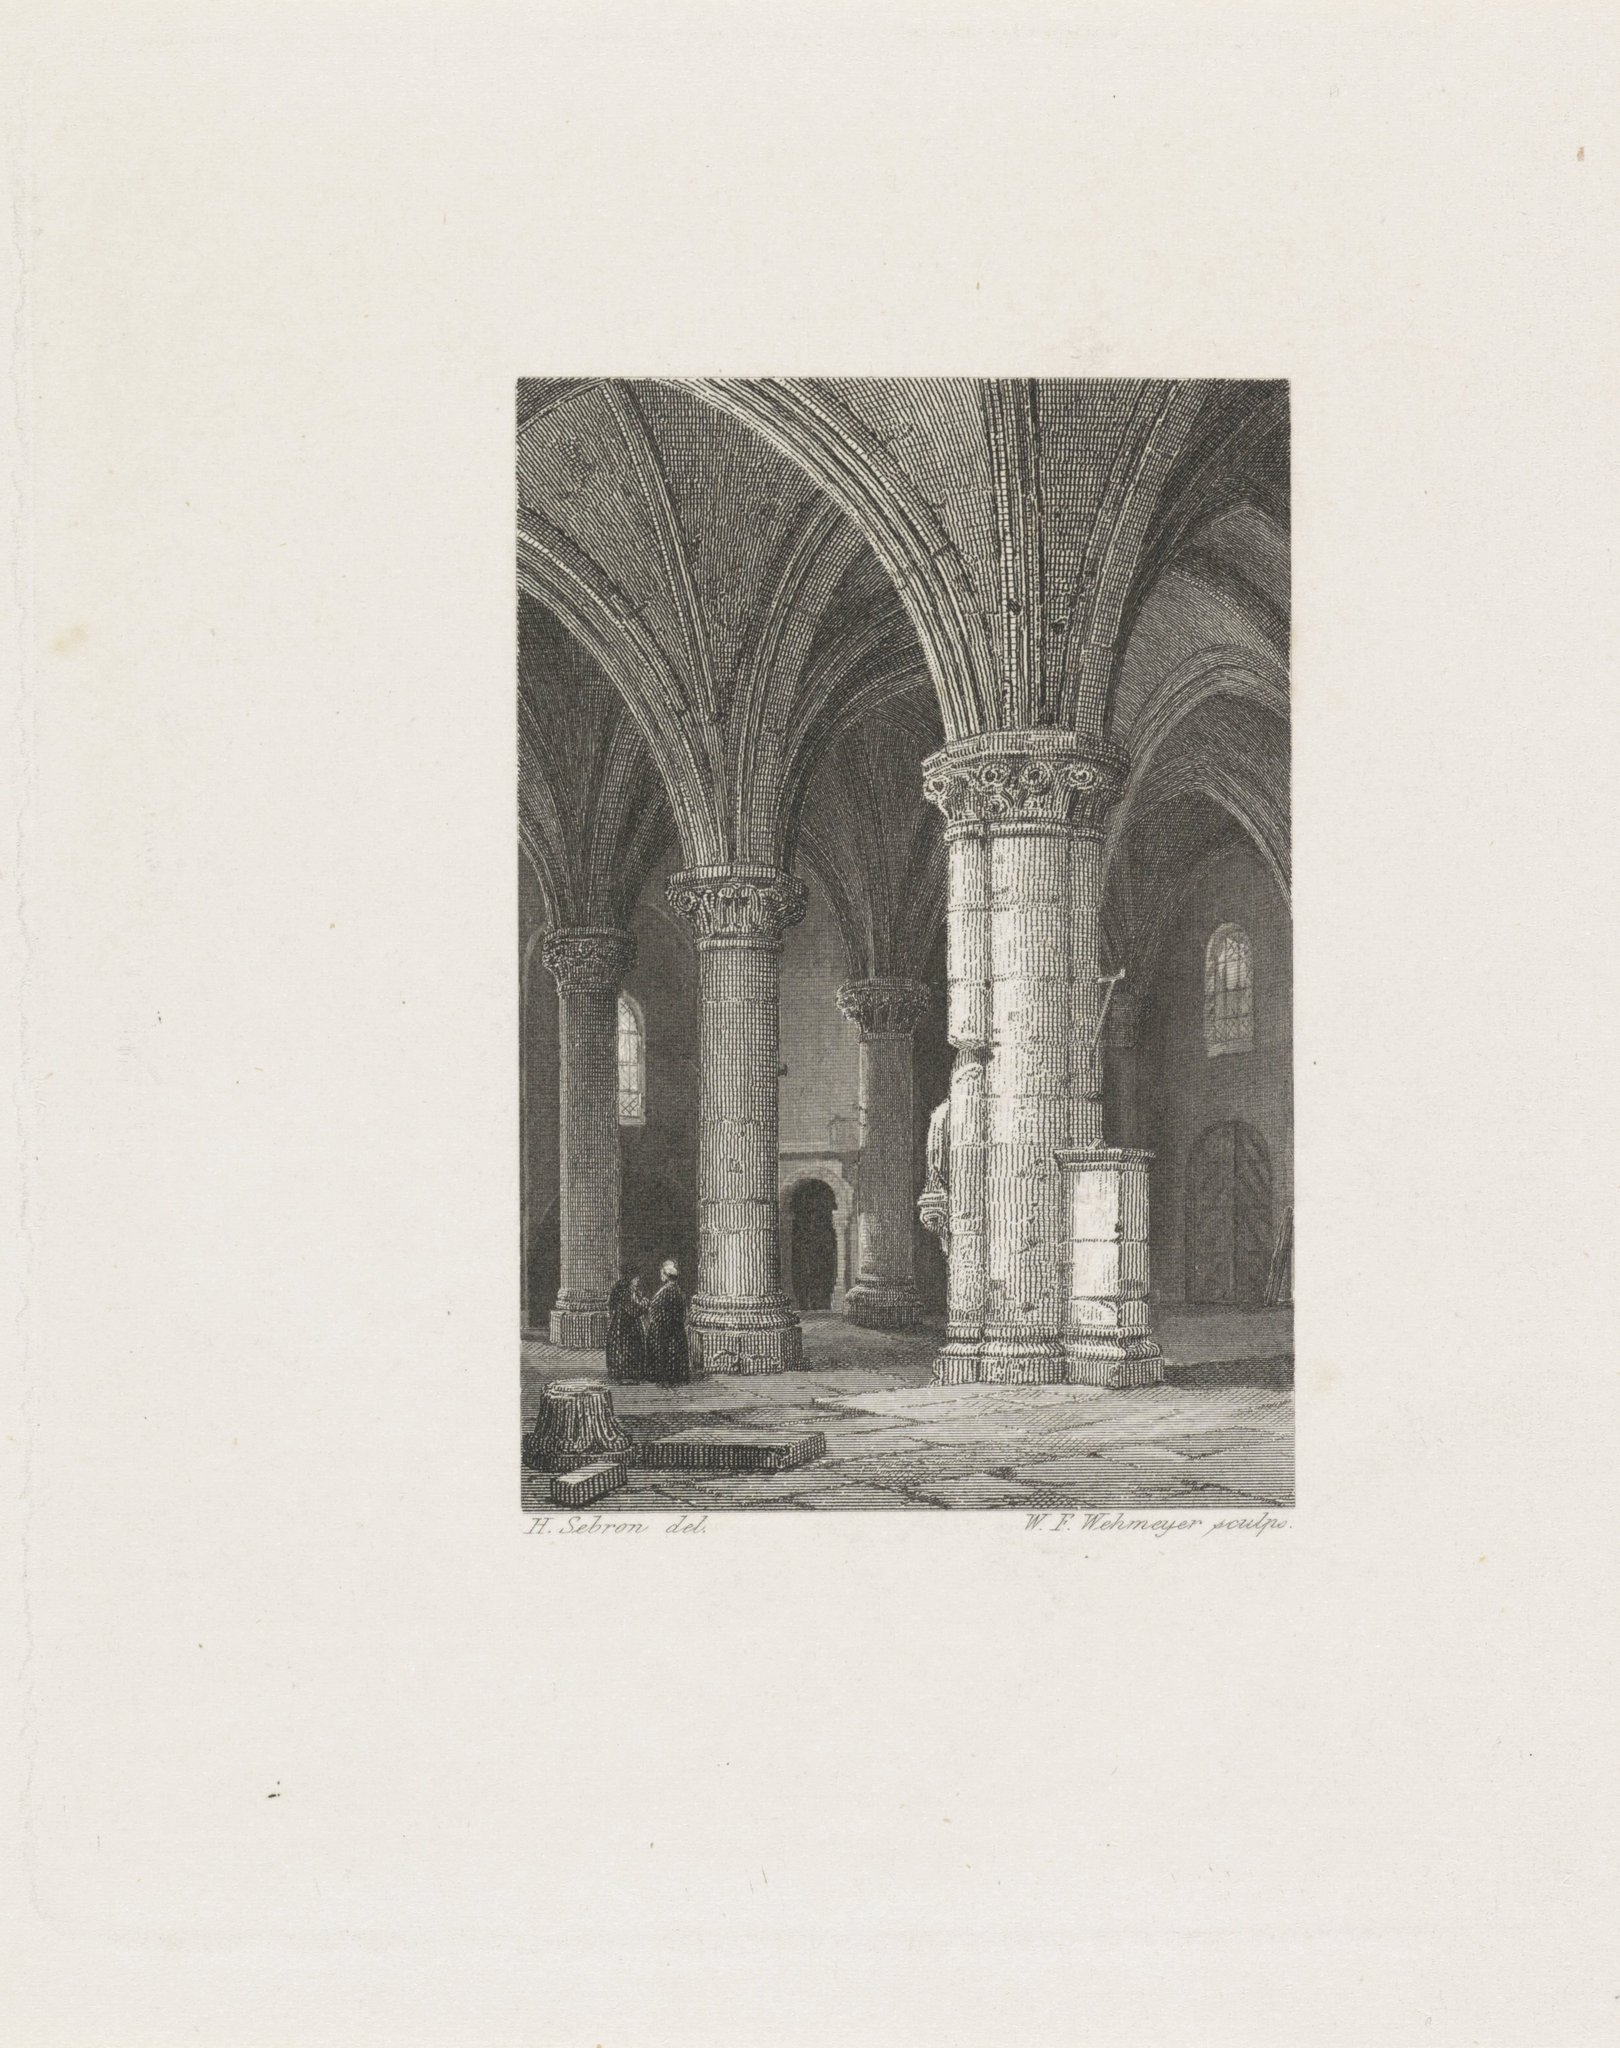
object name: print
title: Kerkinterieur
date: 1839-1854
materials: paper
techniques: engraving, etching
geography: amsterdam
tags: adult woman, interior of church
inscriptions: collector's mark: Lugt 2228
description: Twee vrouwen staan in een kerk met kruisribgewelven.